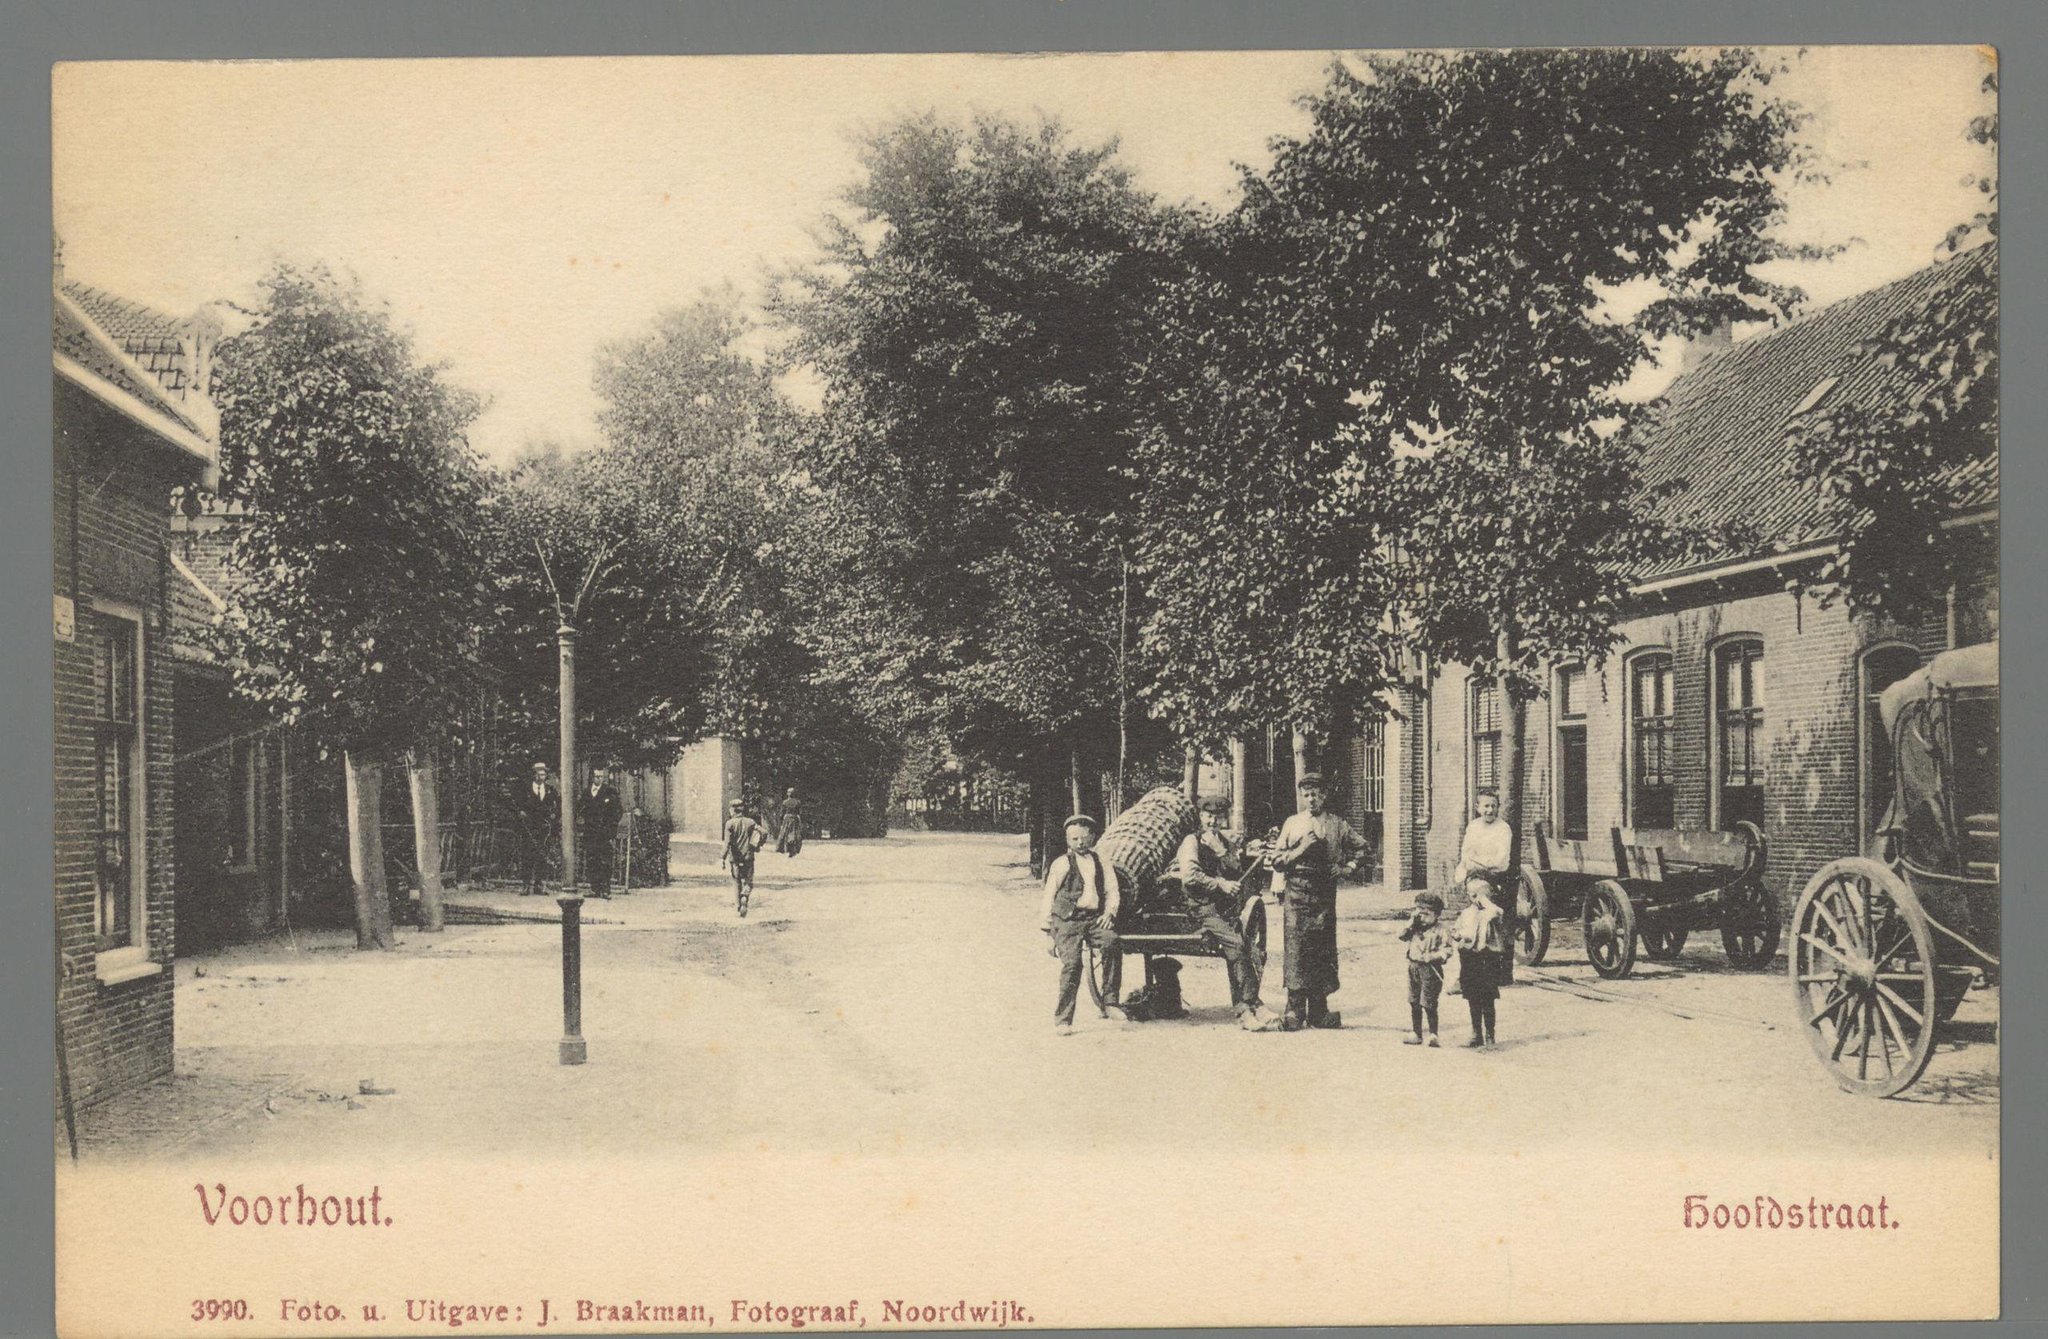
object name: ansichtkaart, prentbriefkaart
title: Voorhout. Hoofdstraat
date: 1905-1930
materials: cardboard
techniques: photograph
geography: voorhout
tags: street